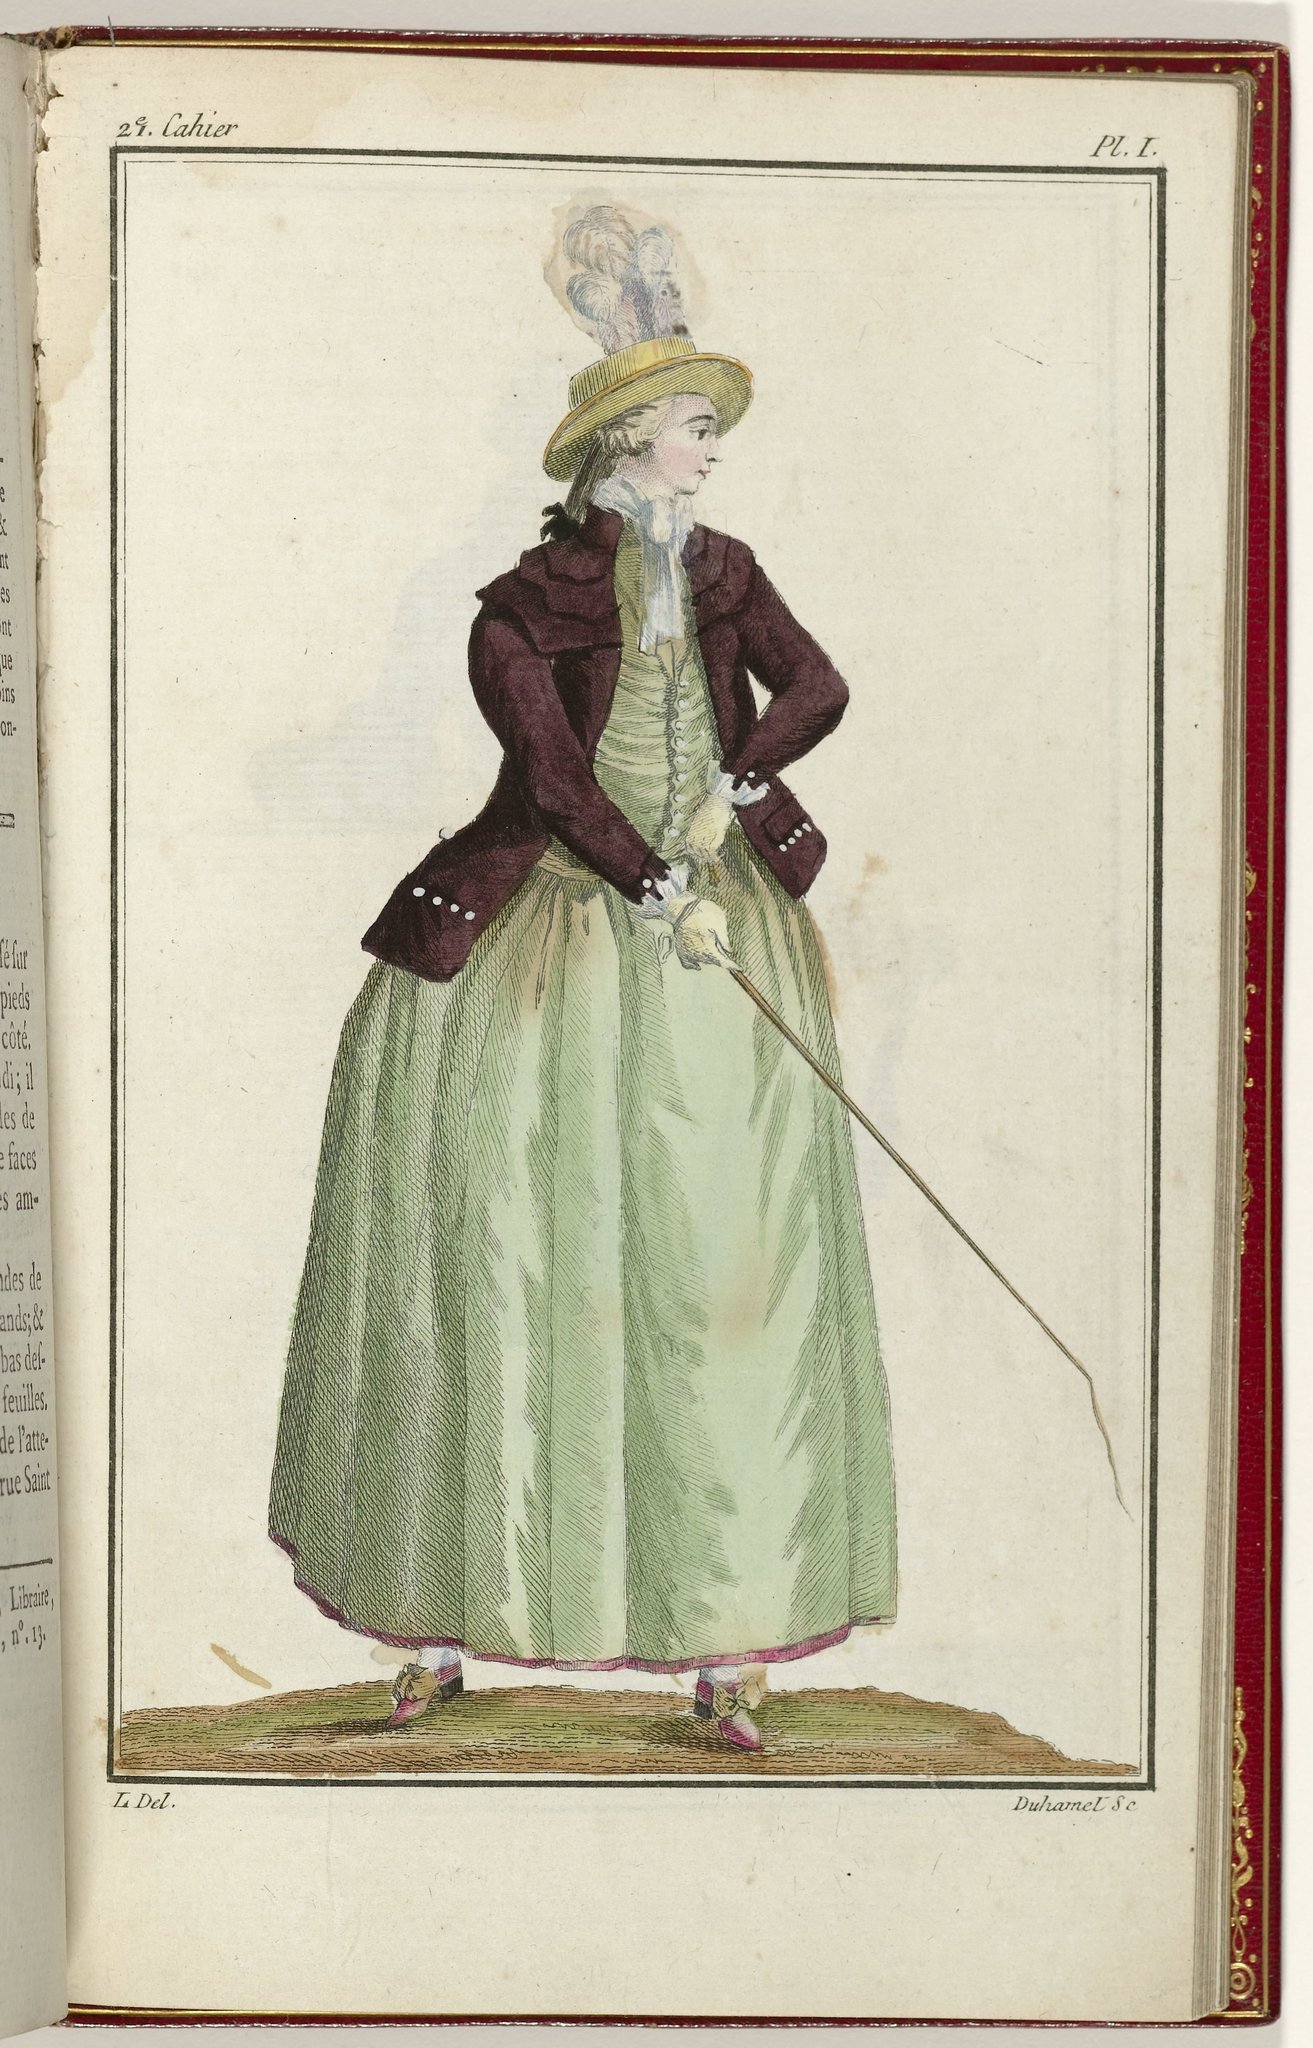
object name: fashion print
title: Cabinet des Modes ou les Modes Nouvelles, 15 Septembre 1786, pl. I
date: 1786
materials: paper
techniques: engraving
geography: paris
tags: clothing for the upper part of the body (+ women's clothes), neck-gear ~ clothing (neckerchief) (+ women's clothes), fashion plates, head-gear: hat (+ women's clothes), shoes, sandals (+ women's clothes), skirt (+ women's clothes), gloves, mittens, etc. (+ women's clothes), whip, ensembles of pieces of clothing (riding costume) (+ women's clothes)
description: Amazonekostuum. Volgens de begeleidende tekst draagt de vrouw een rijkostuum of amazonekostuum. Het bestaat uit een jasje met drie schouderkragen, een vest en een rok van appelgroene zijde. Geknoopte halsdoek. Kousen. Accessoires: hoed van geel wolvilt versierd met veren, handschoenen, zweep, schoenen met hakken en strikken. De prent maakt deel uit van het 21e Cahier uit de serie Cabinet des Modes ou les Modes Nouvelles. De serie bestaat uit 72 modeprenten, uitgegeven door Buisson, Parijs, 15 november 1785 - 1 november 1786.